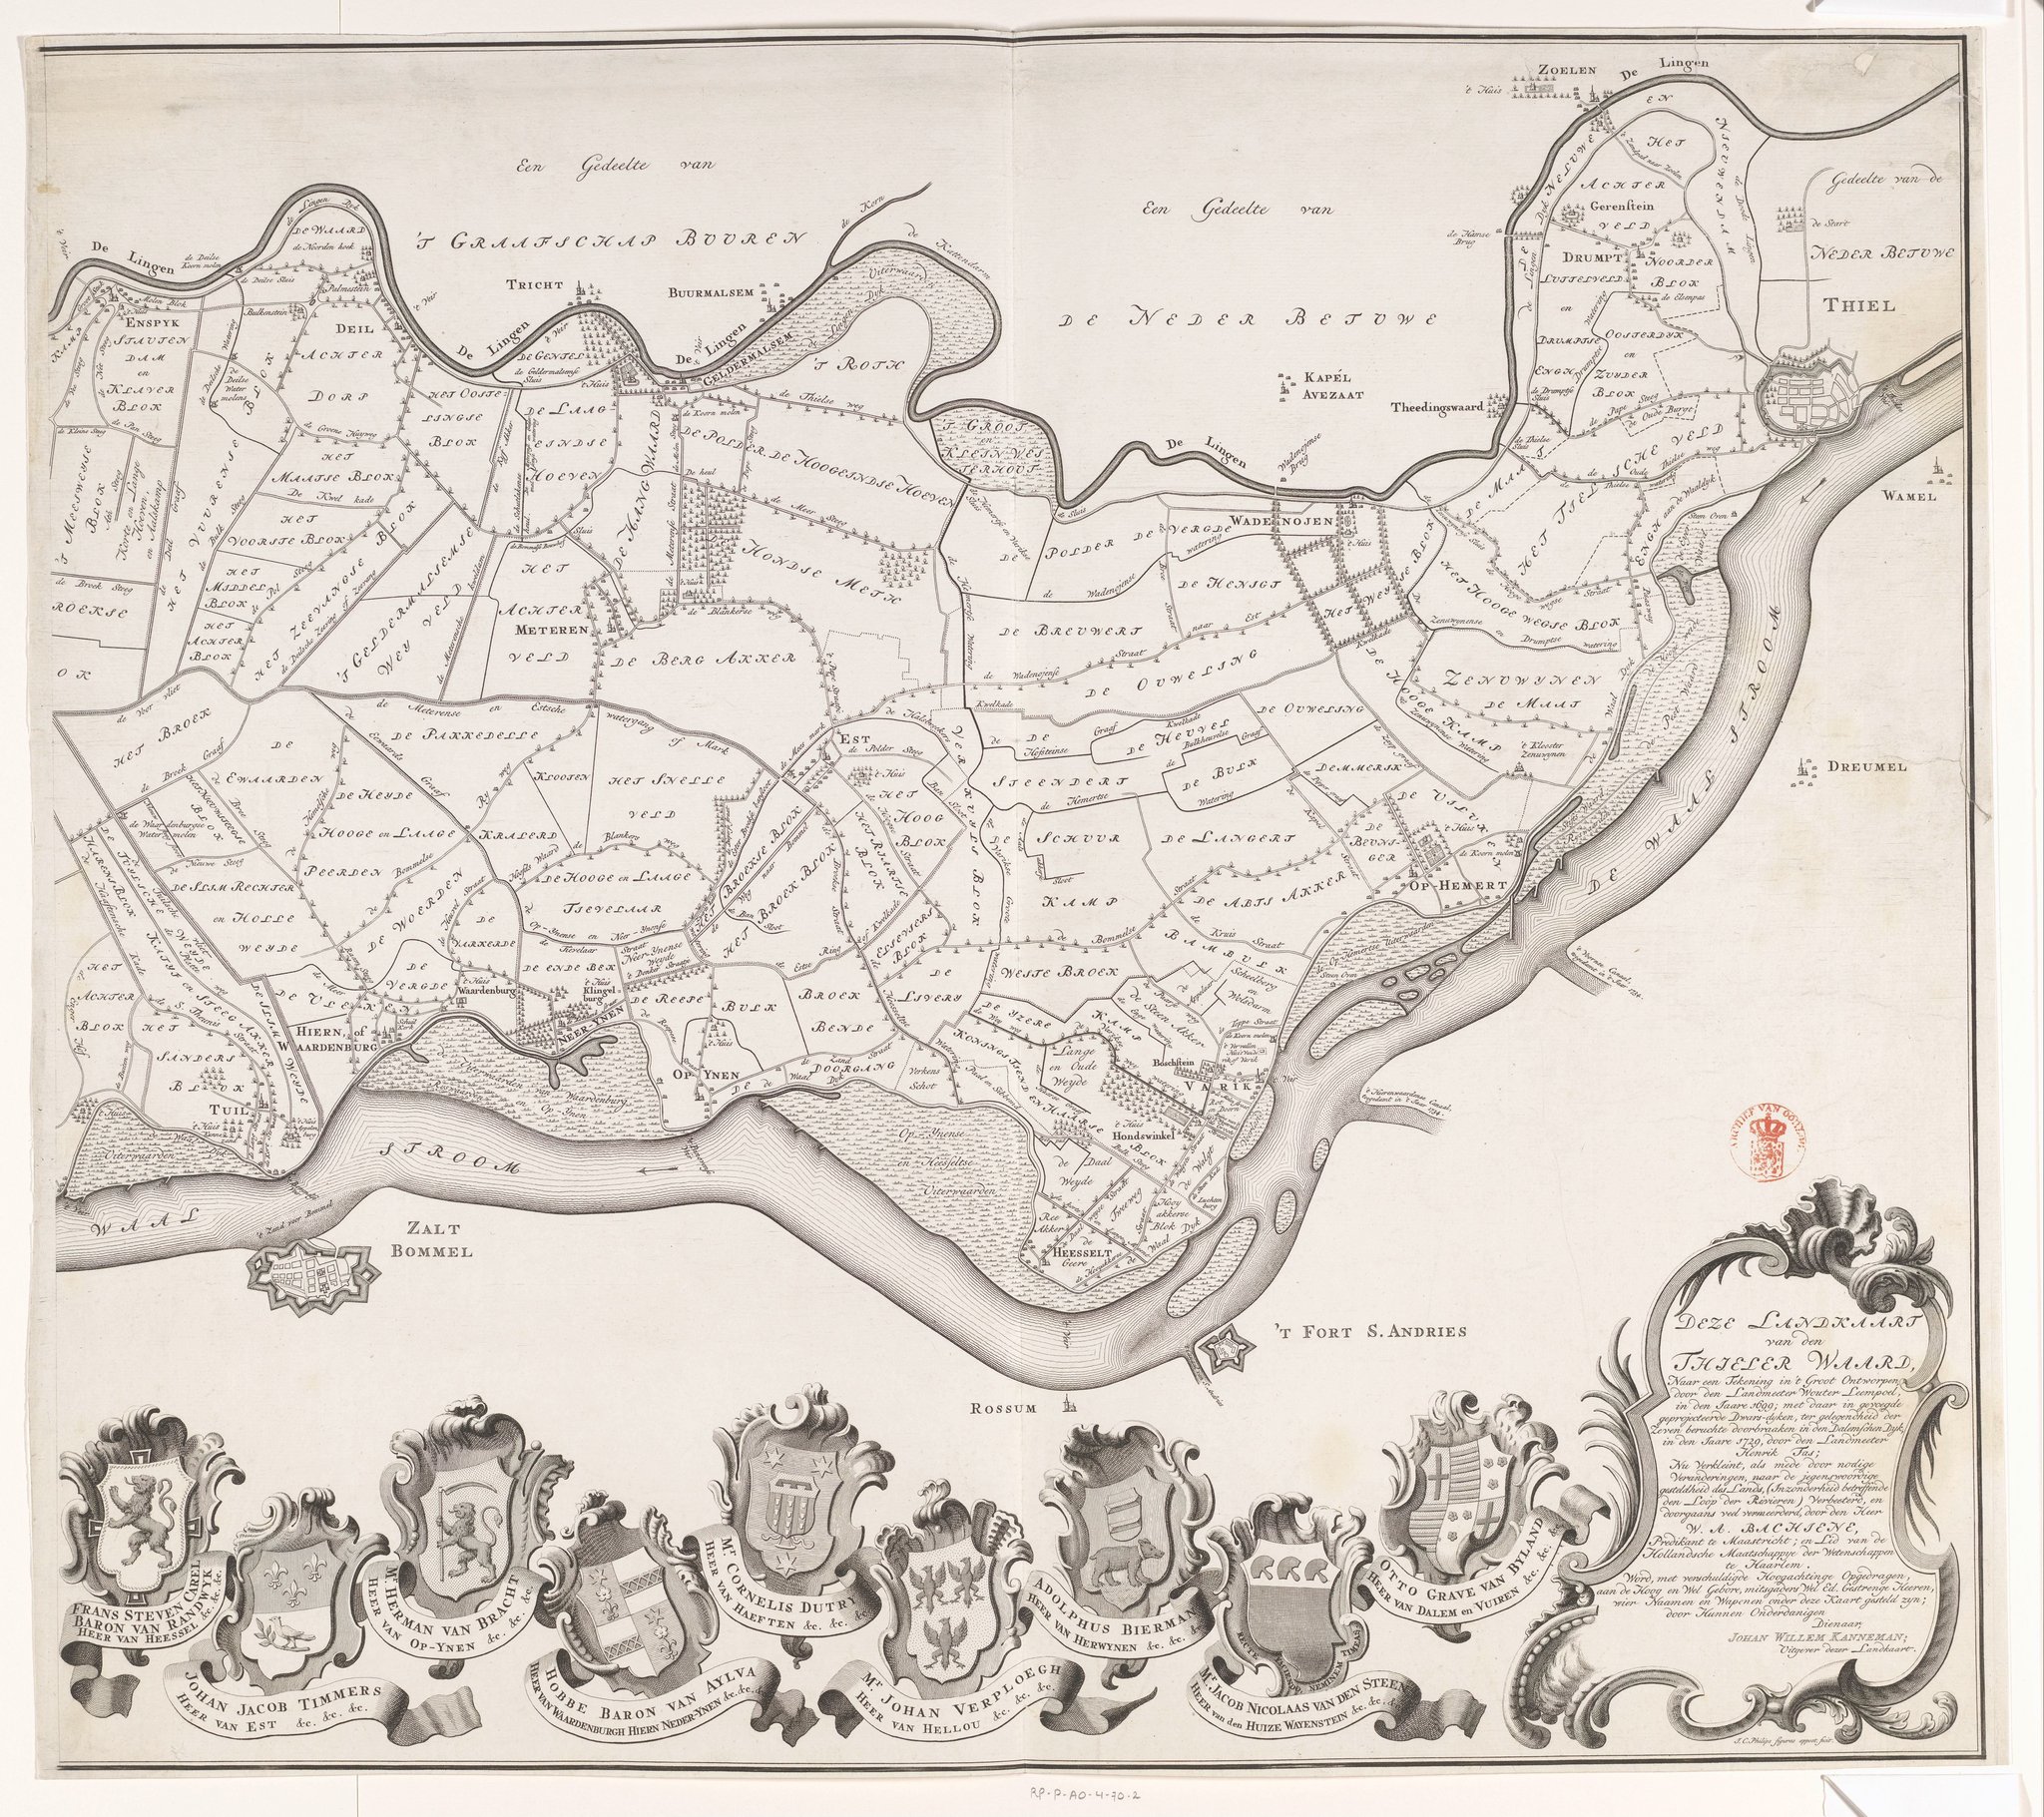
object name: print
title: Deze landkaart van den Thieler Waard (...)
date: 1759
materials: paper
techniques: engraving, etching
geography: amsterdam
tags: coat of arms (as symbol of the state, etc.), maps of separate countries or regions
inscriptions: collector's mark: Lugt 2228, collector's mark: Lugt 19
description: Rechterdeel van een kaart van de Tielerwaard.